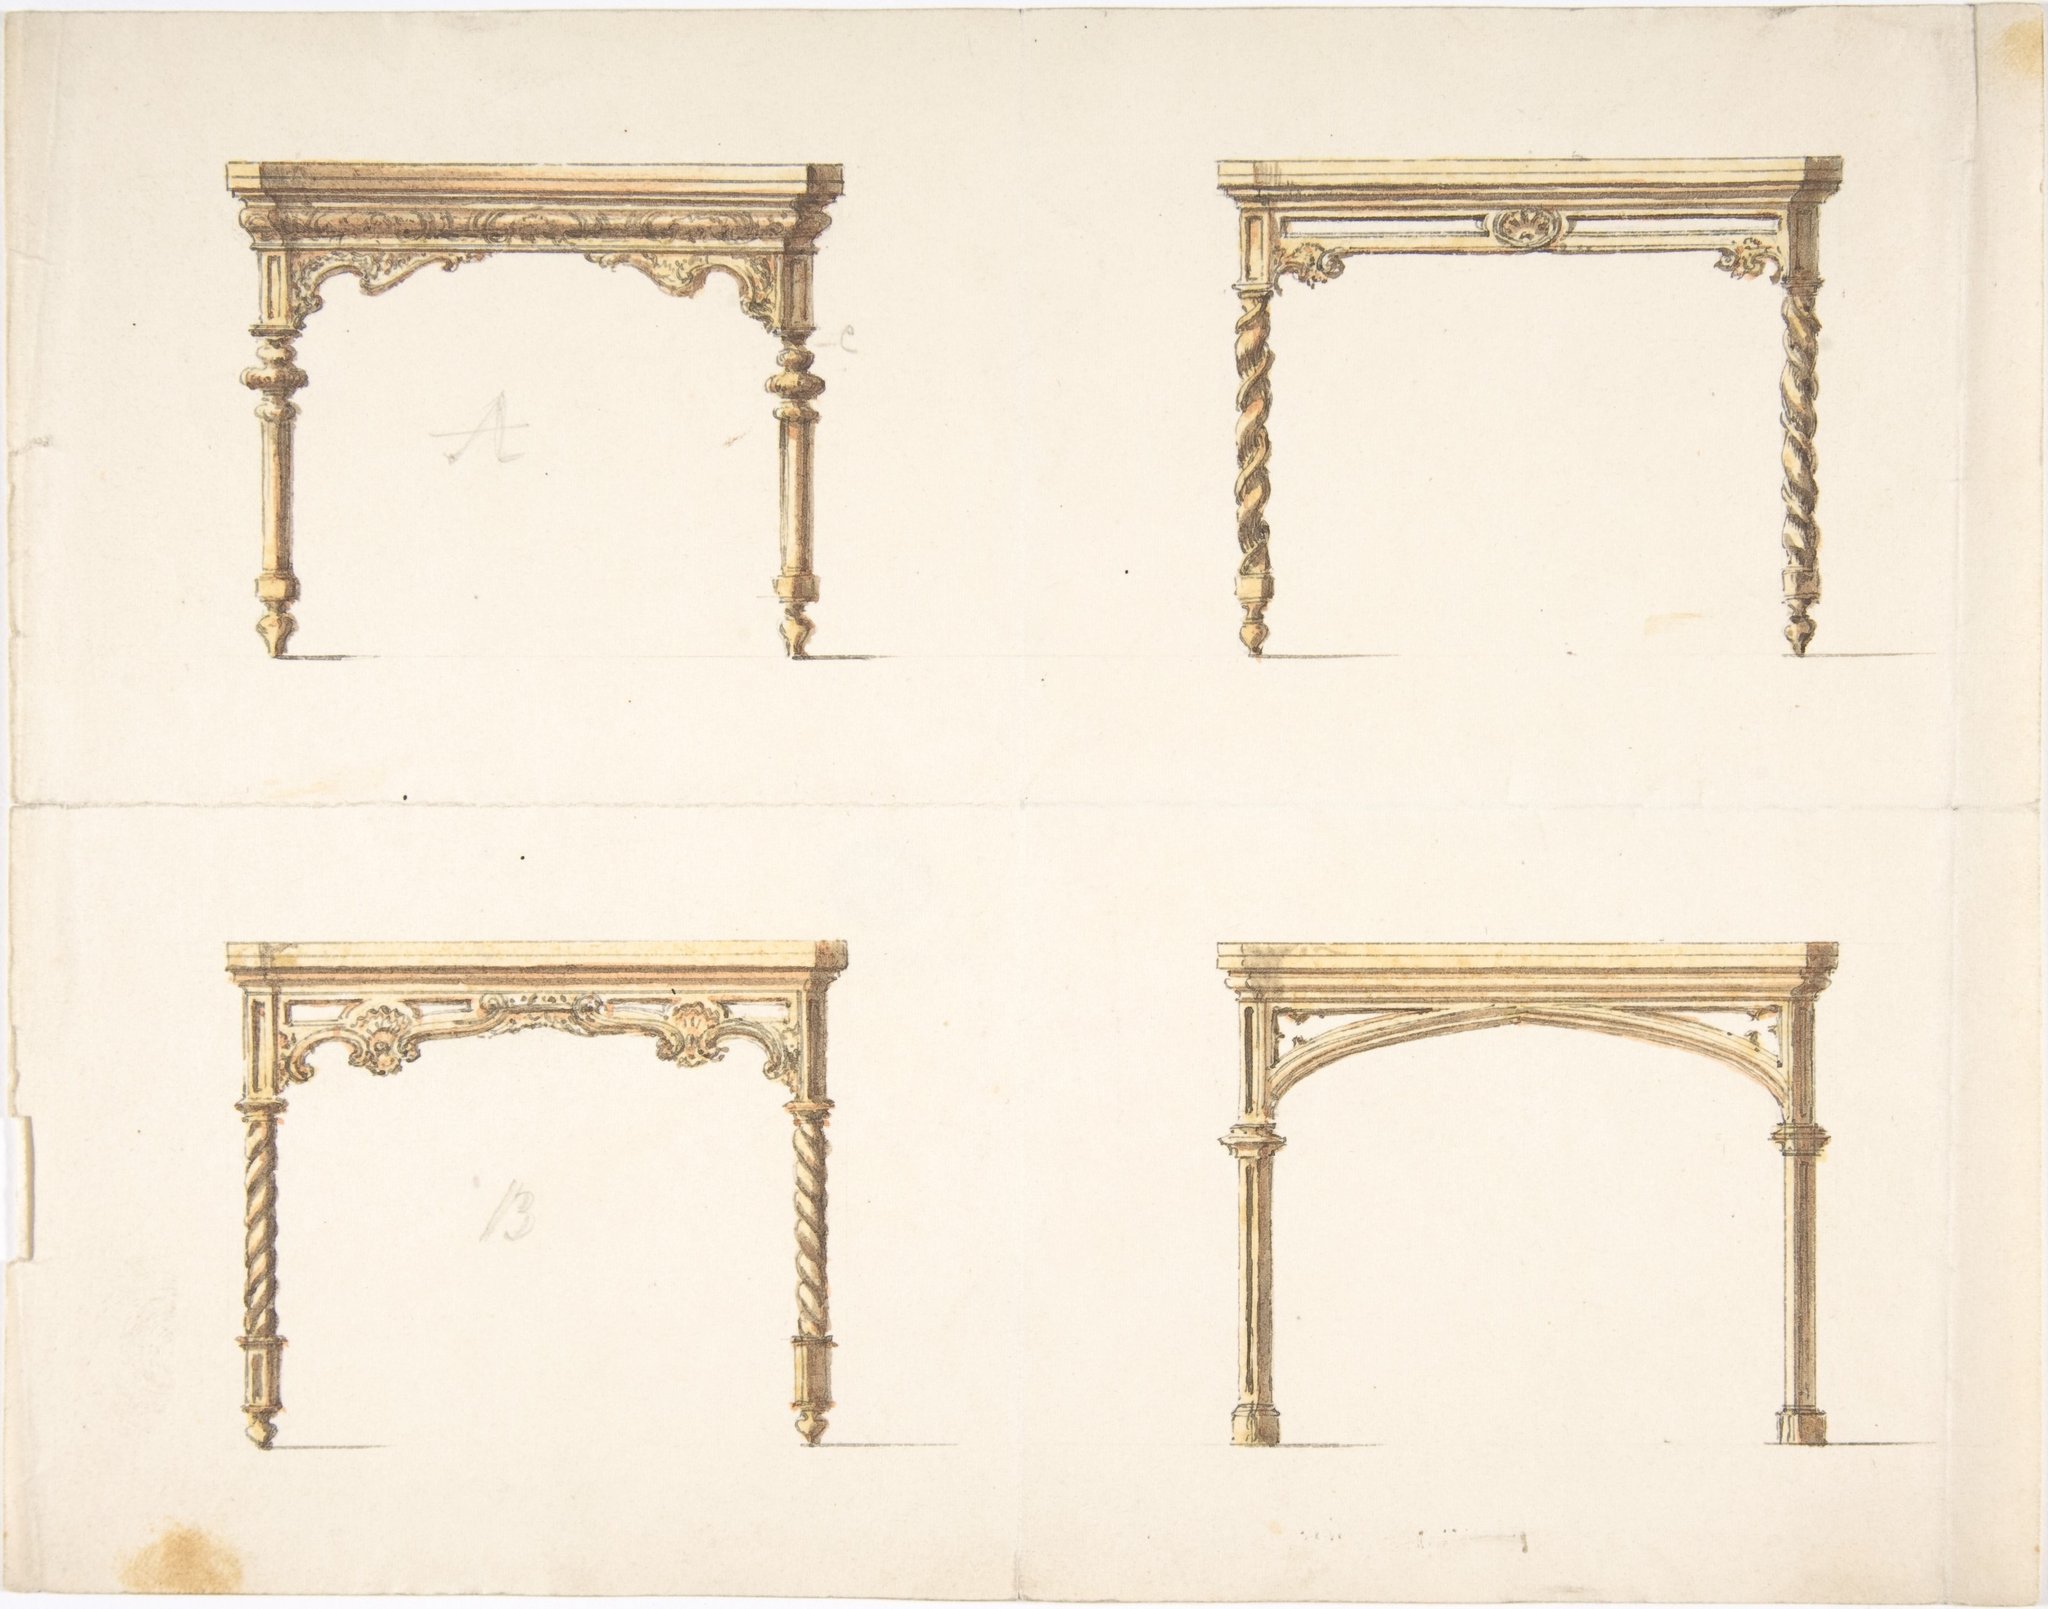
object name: drawing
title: Design for Four Table Ends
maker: anonymous, british, 19th century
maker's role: artist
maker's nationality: british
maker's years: 1800-1900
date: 1801-1833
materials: ink, watercolor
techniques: pen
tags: tables